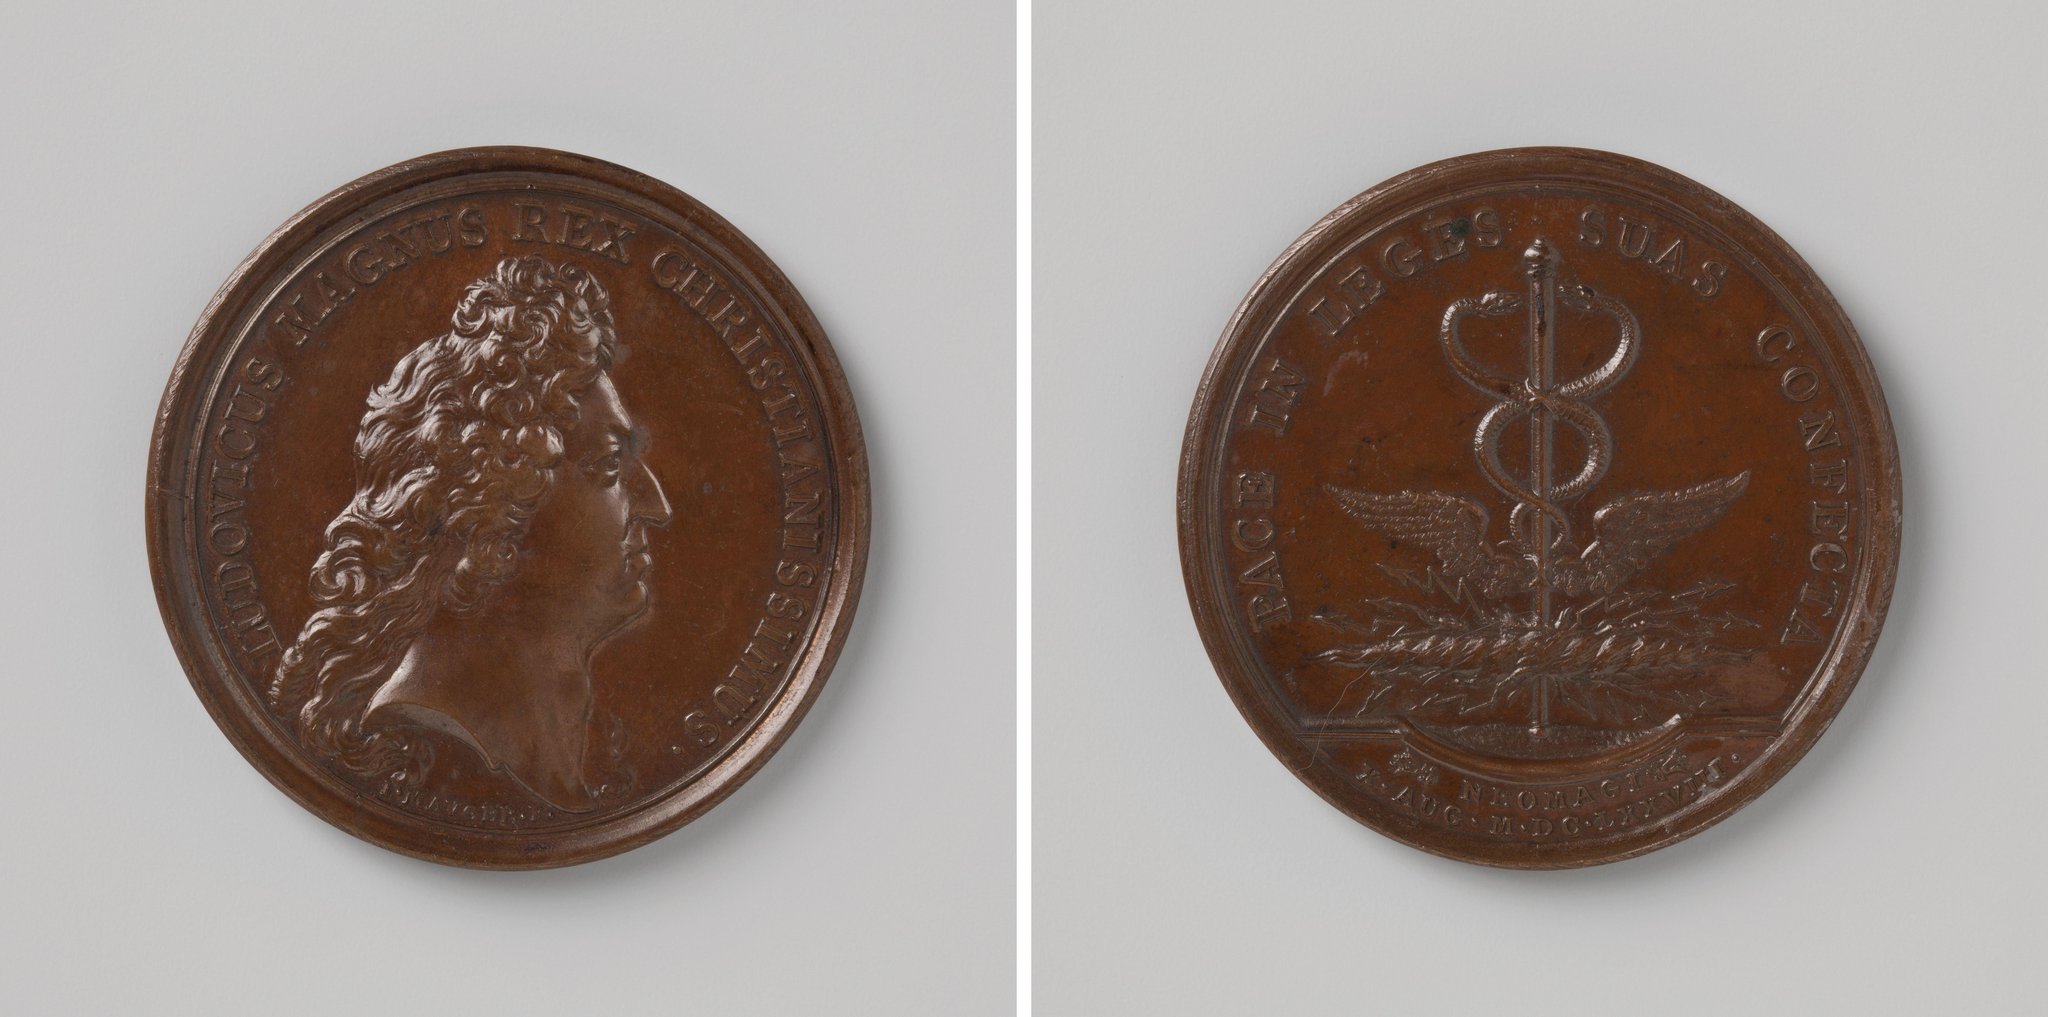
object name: history medal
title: Vrede van Nijmegen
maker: Anonymous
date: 1678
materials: silver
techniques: striking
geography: netherlands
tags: nijmegen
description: Commemorative medal marking the Treaty of Nijmegen of 1678. On 10 August 1678 a treaty was signed in Nijmegen between the Dutch Republic and France. It brought an end to a war which had started in 1672 with the attack by France and her allies against the Republic.